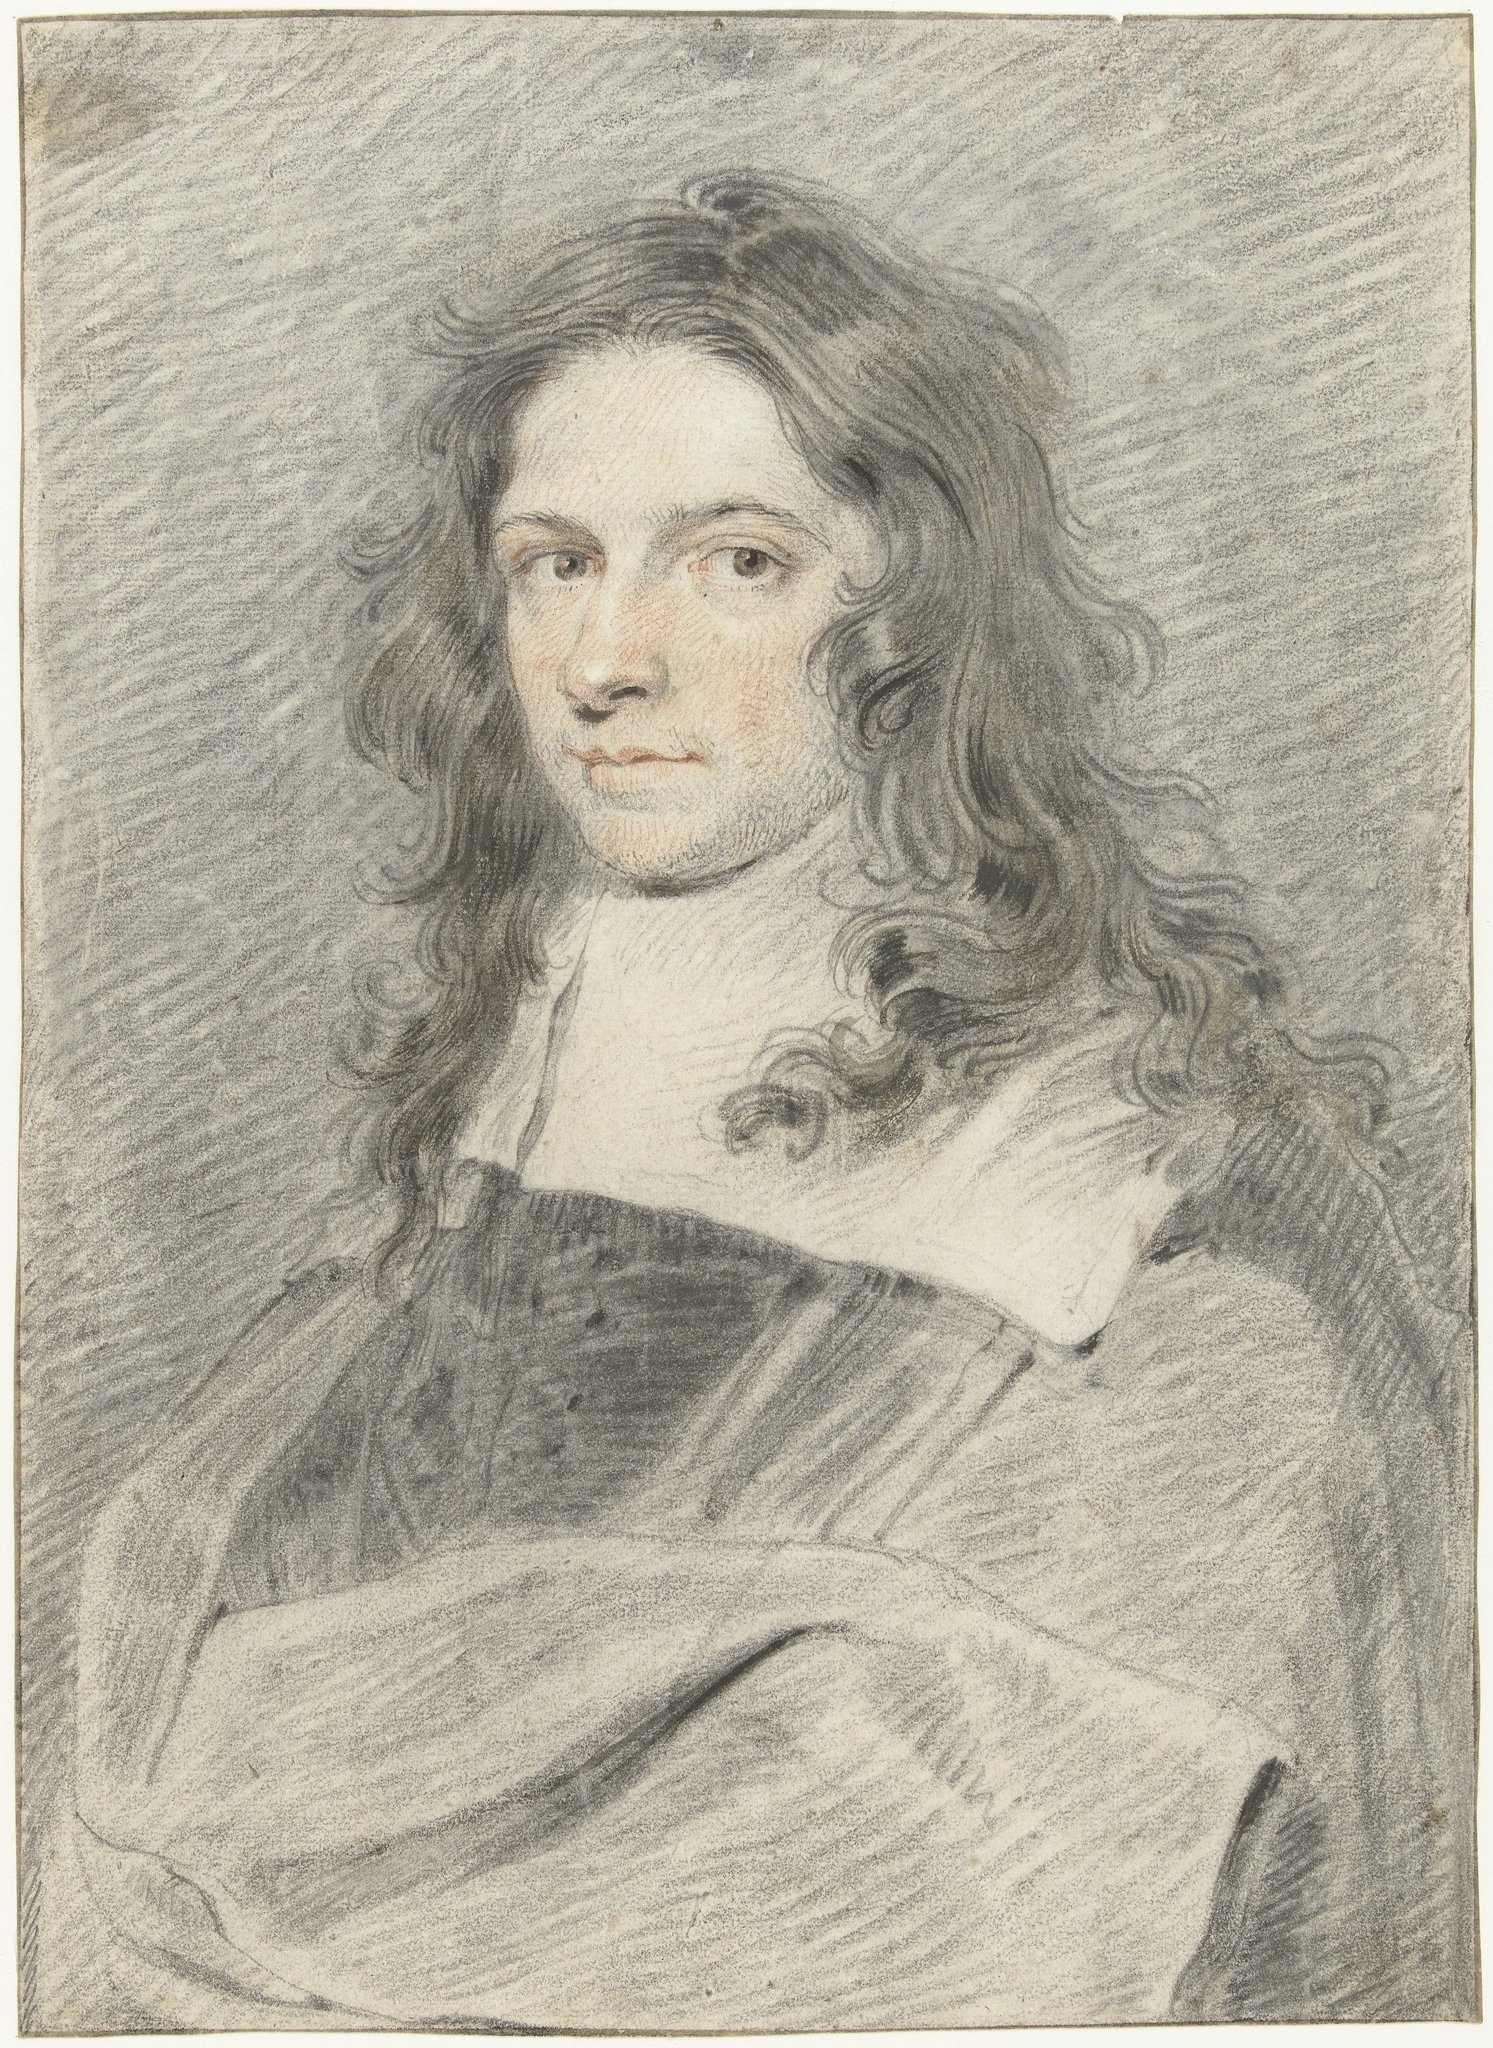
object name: drawing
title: Portret van een jonge magistraat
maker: jan cossiers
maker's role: draughtsman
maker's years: 1600-1671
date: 1610-1677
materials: chalk, ink, paper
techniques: pen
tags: anonymous historical person portrayed alone, male sex; man